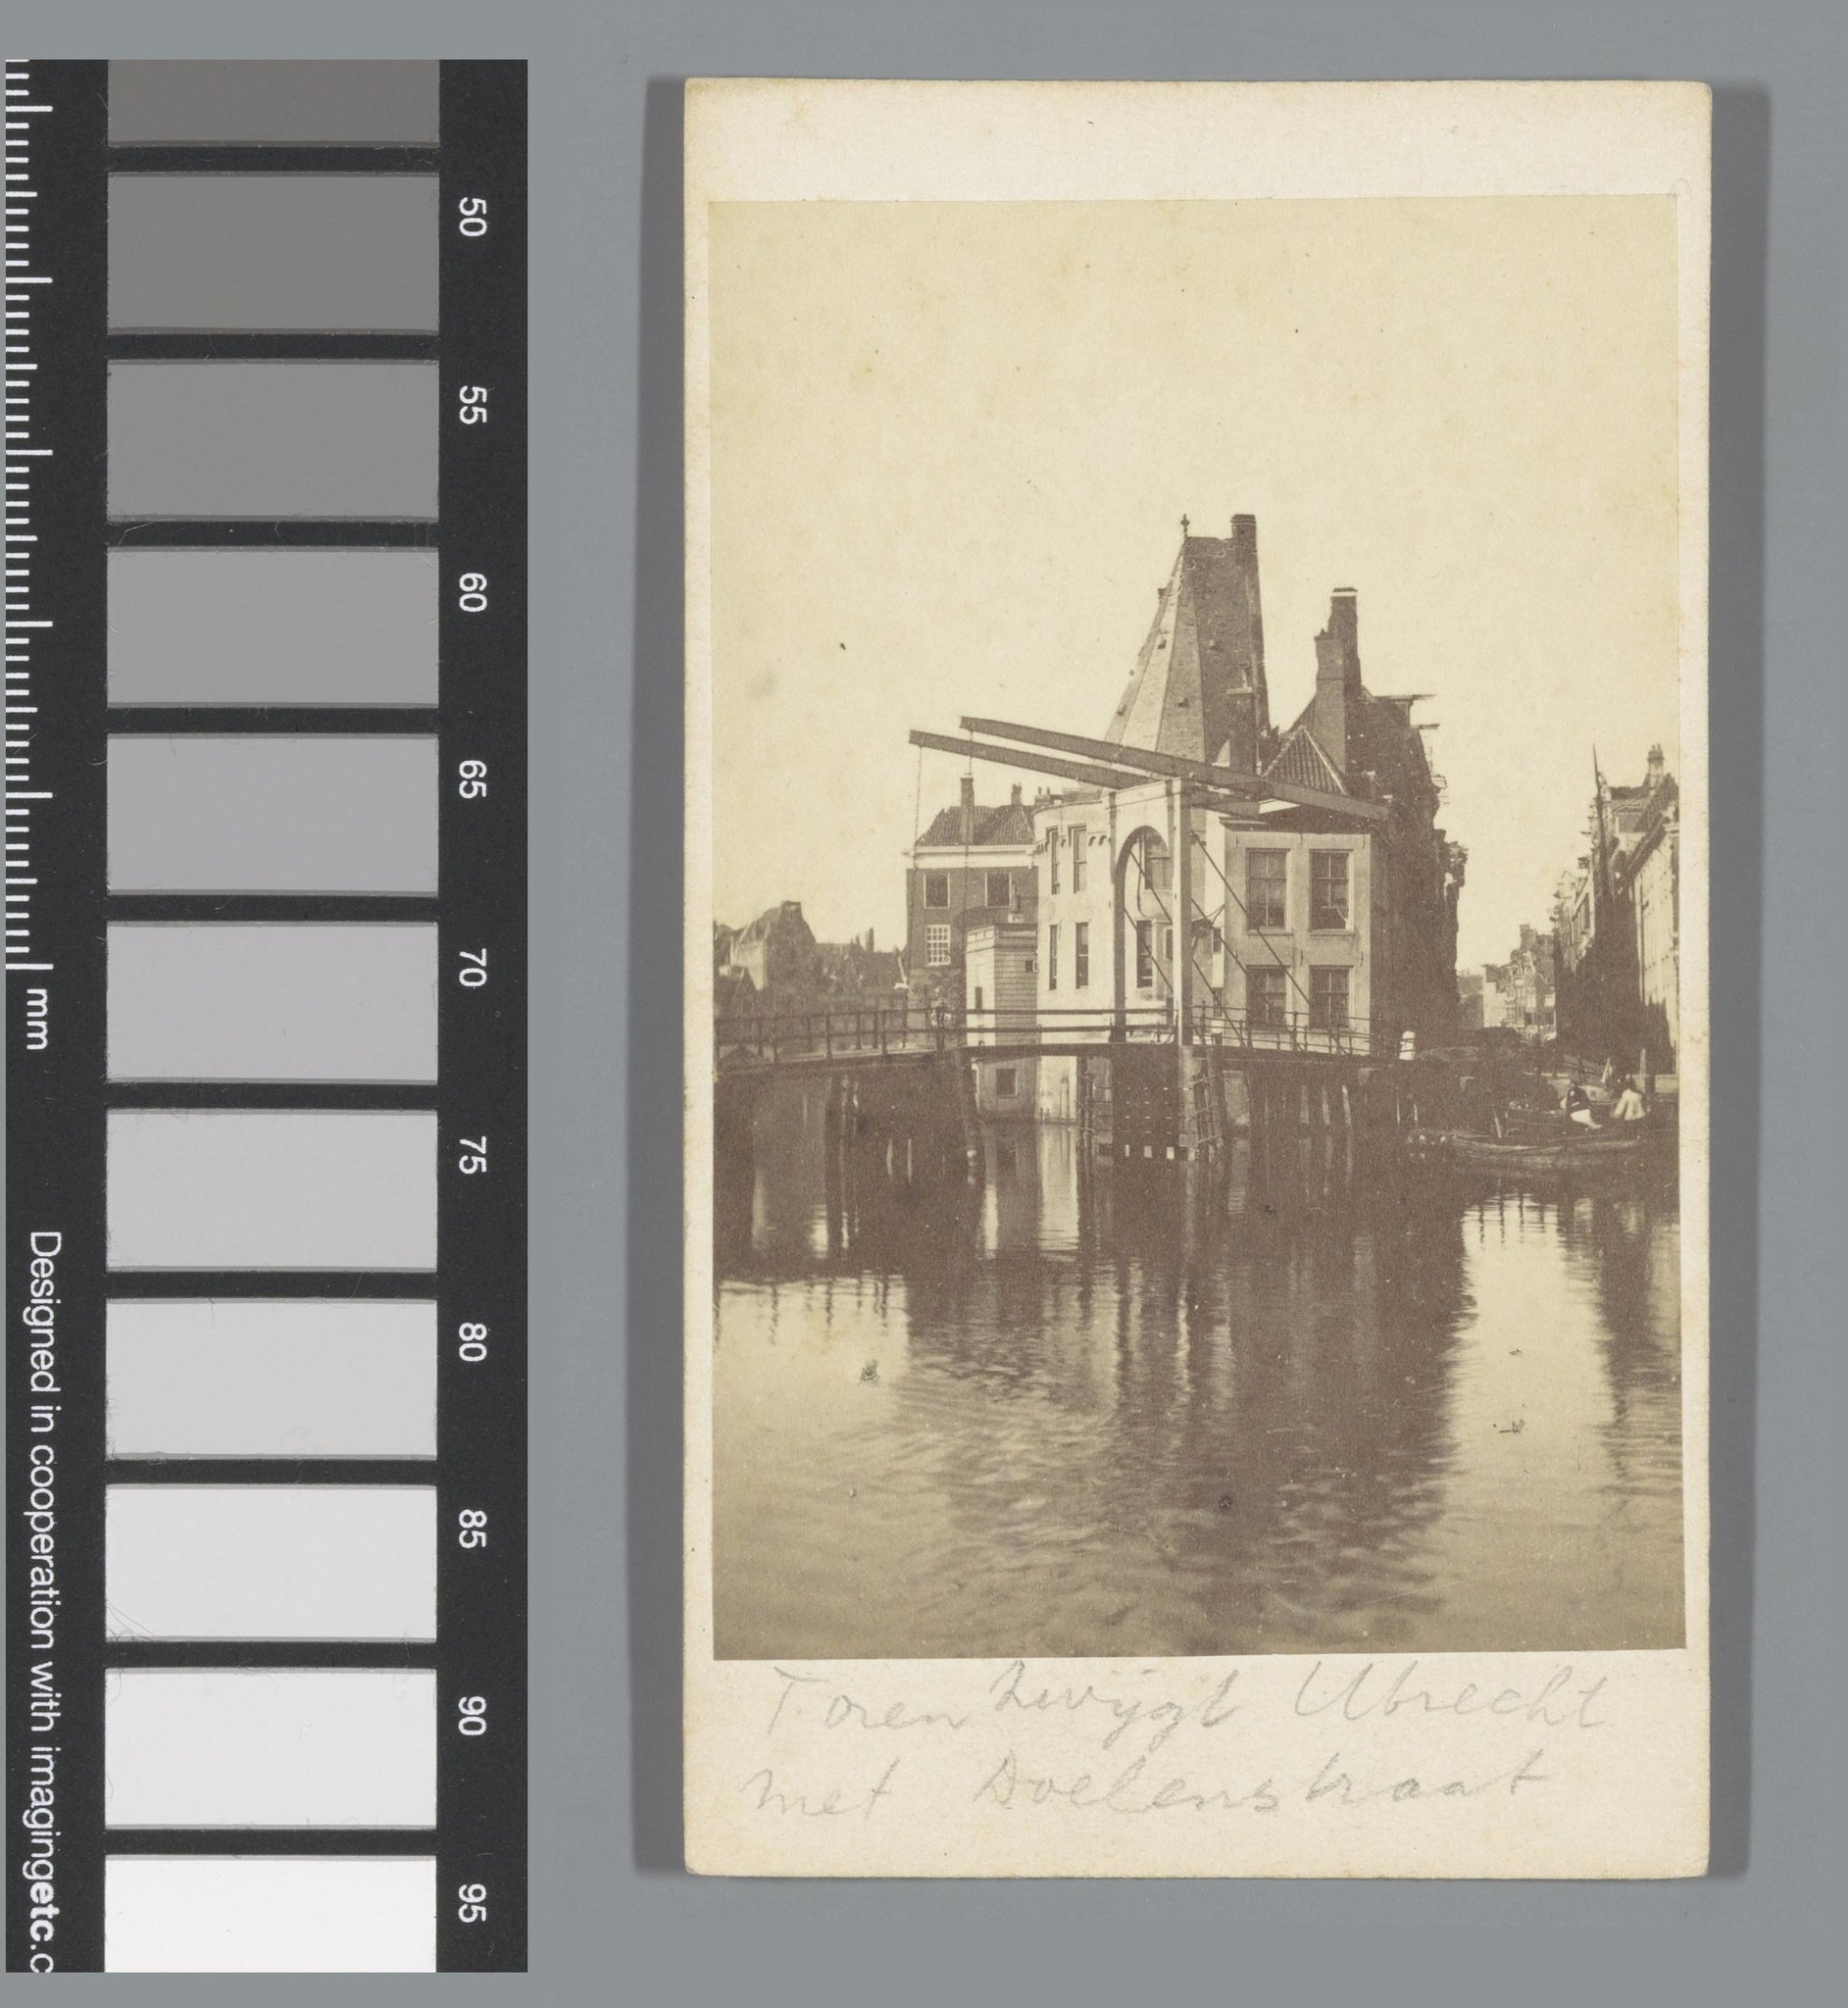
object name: photograph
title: Gezicht op de toren Swych Utrecht en de Doelenstraat in Amsterdam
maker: andries jager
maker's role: publisher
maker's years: 1825-1905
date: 1860-1890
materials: cardboard, photographic support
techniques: albumen print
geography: amsterdam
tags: city-walls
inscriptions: address: ‘A. Jager/ Water, 110/ AMSTERDAM.’, annotation: ‘Toren Zwijgt Utrecht/ met Doelenstraat’